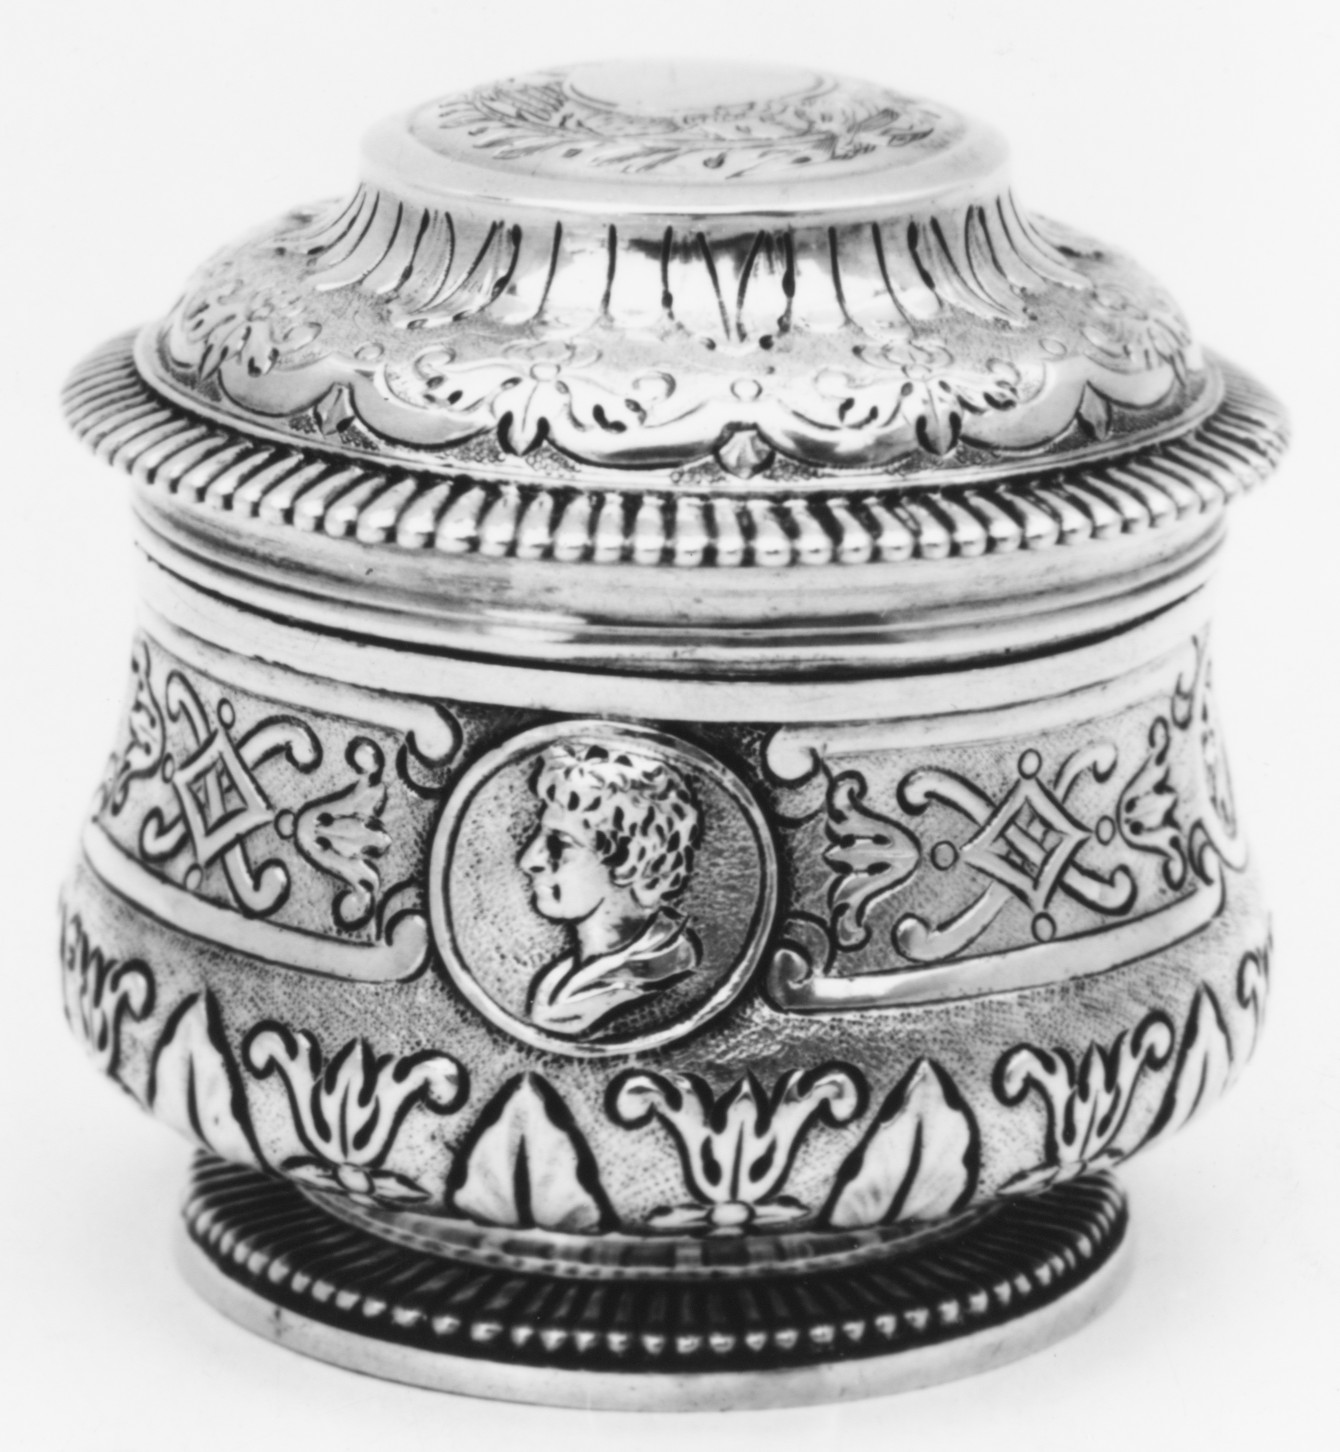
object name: box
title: Box (one of a pair) (part of a toilet service)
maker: jean-baptiste boullemer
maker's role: maker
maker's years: 1682-1739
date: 1726-1728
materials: silver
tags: men,profiles